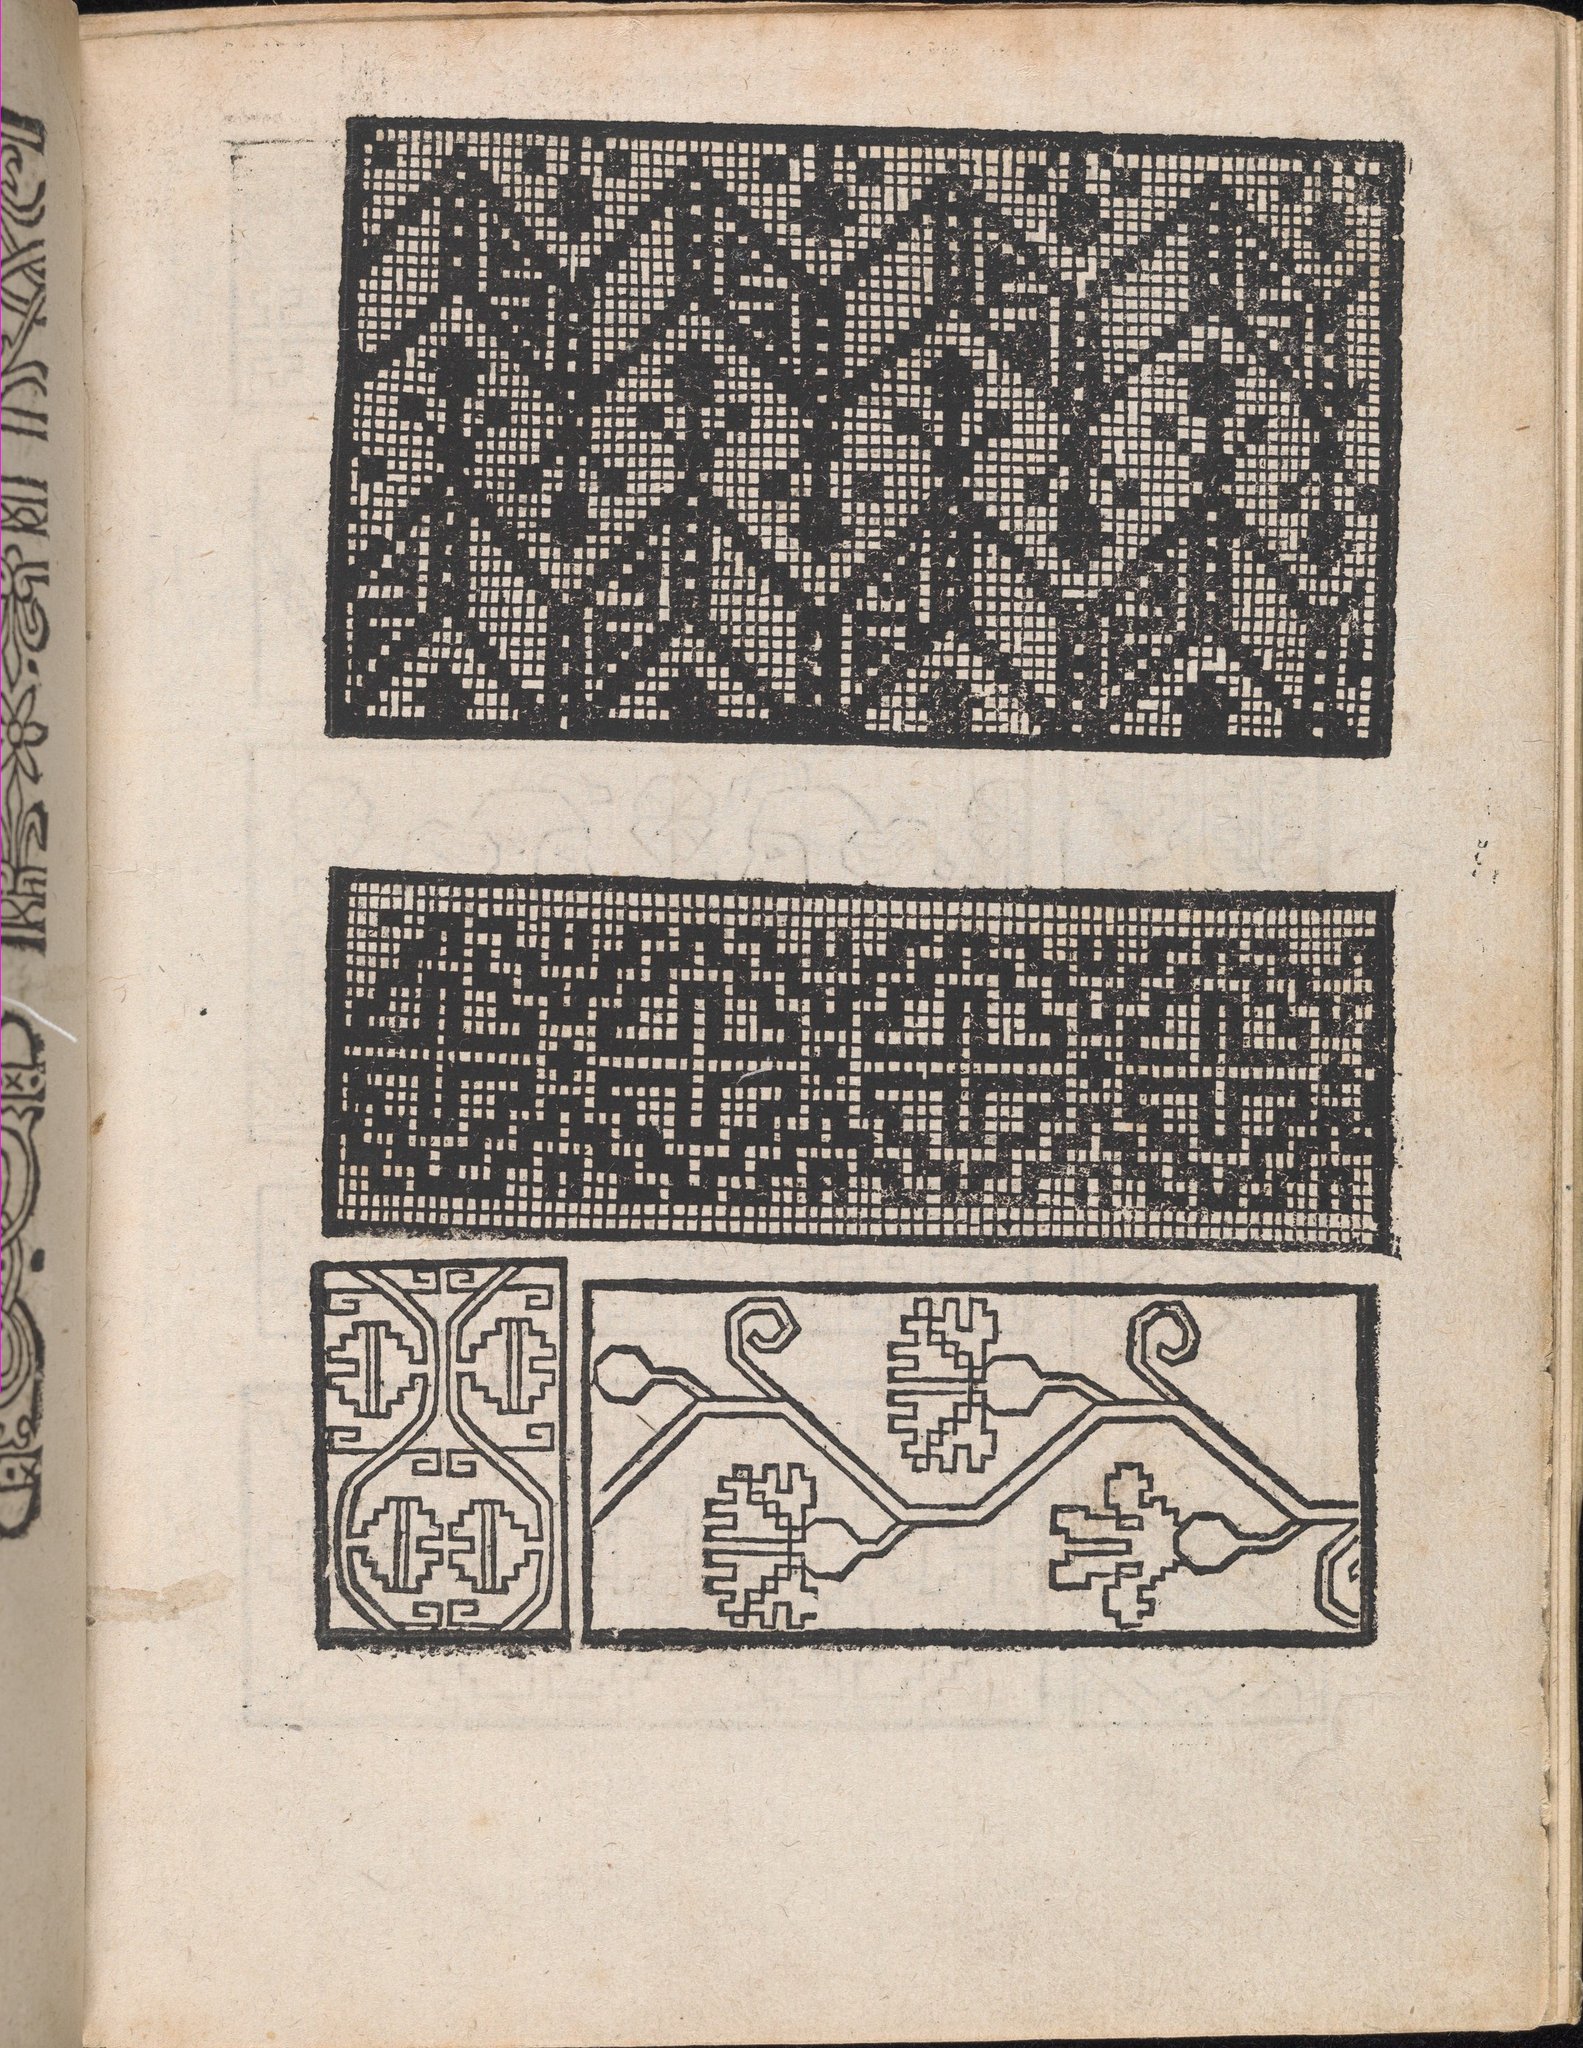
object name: book print ornament architecture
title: Modelbuch aller Art Nehens vn Stickens (Page 4r)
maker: christian egenolff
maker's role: publisher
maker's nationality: german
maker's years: 1502-1555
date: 1535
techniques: woodcut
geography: germany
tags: ornament